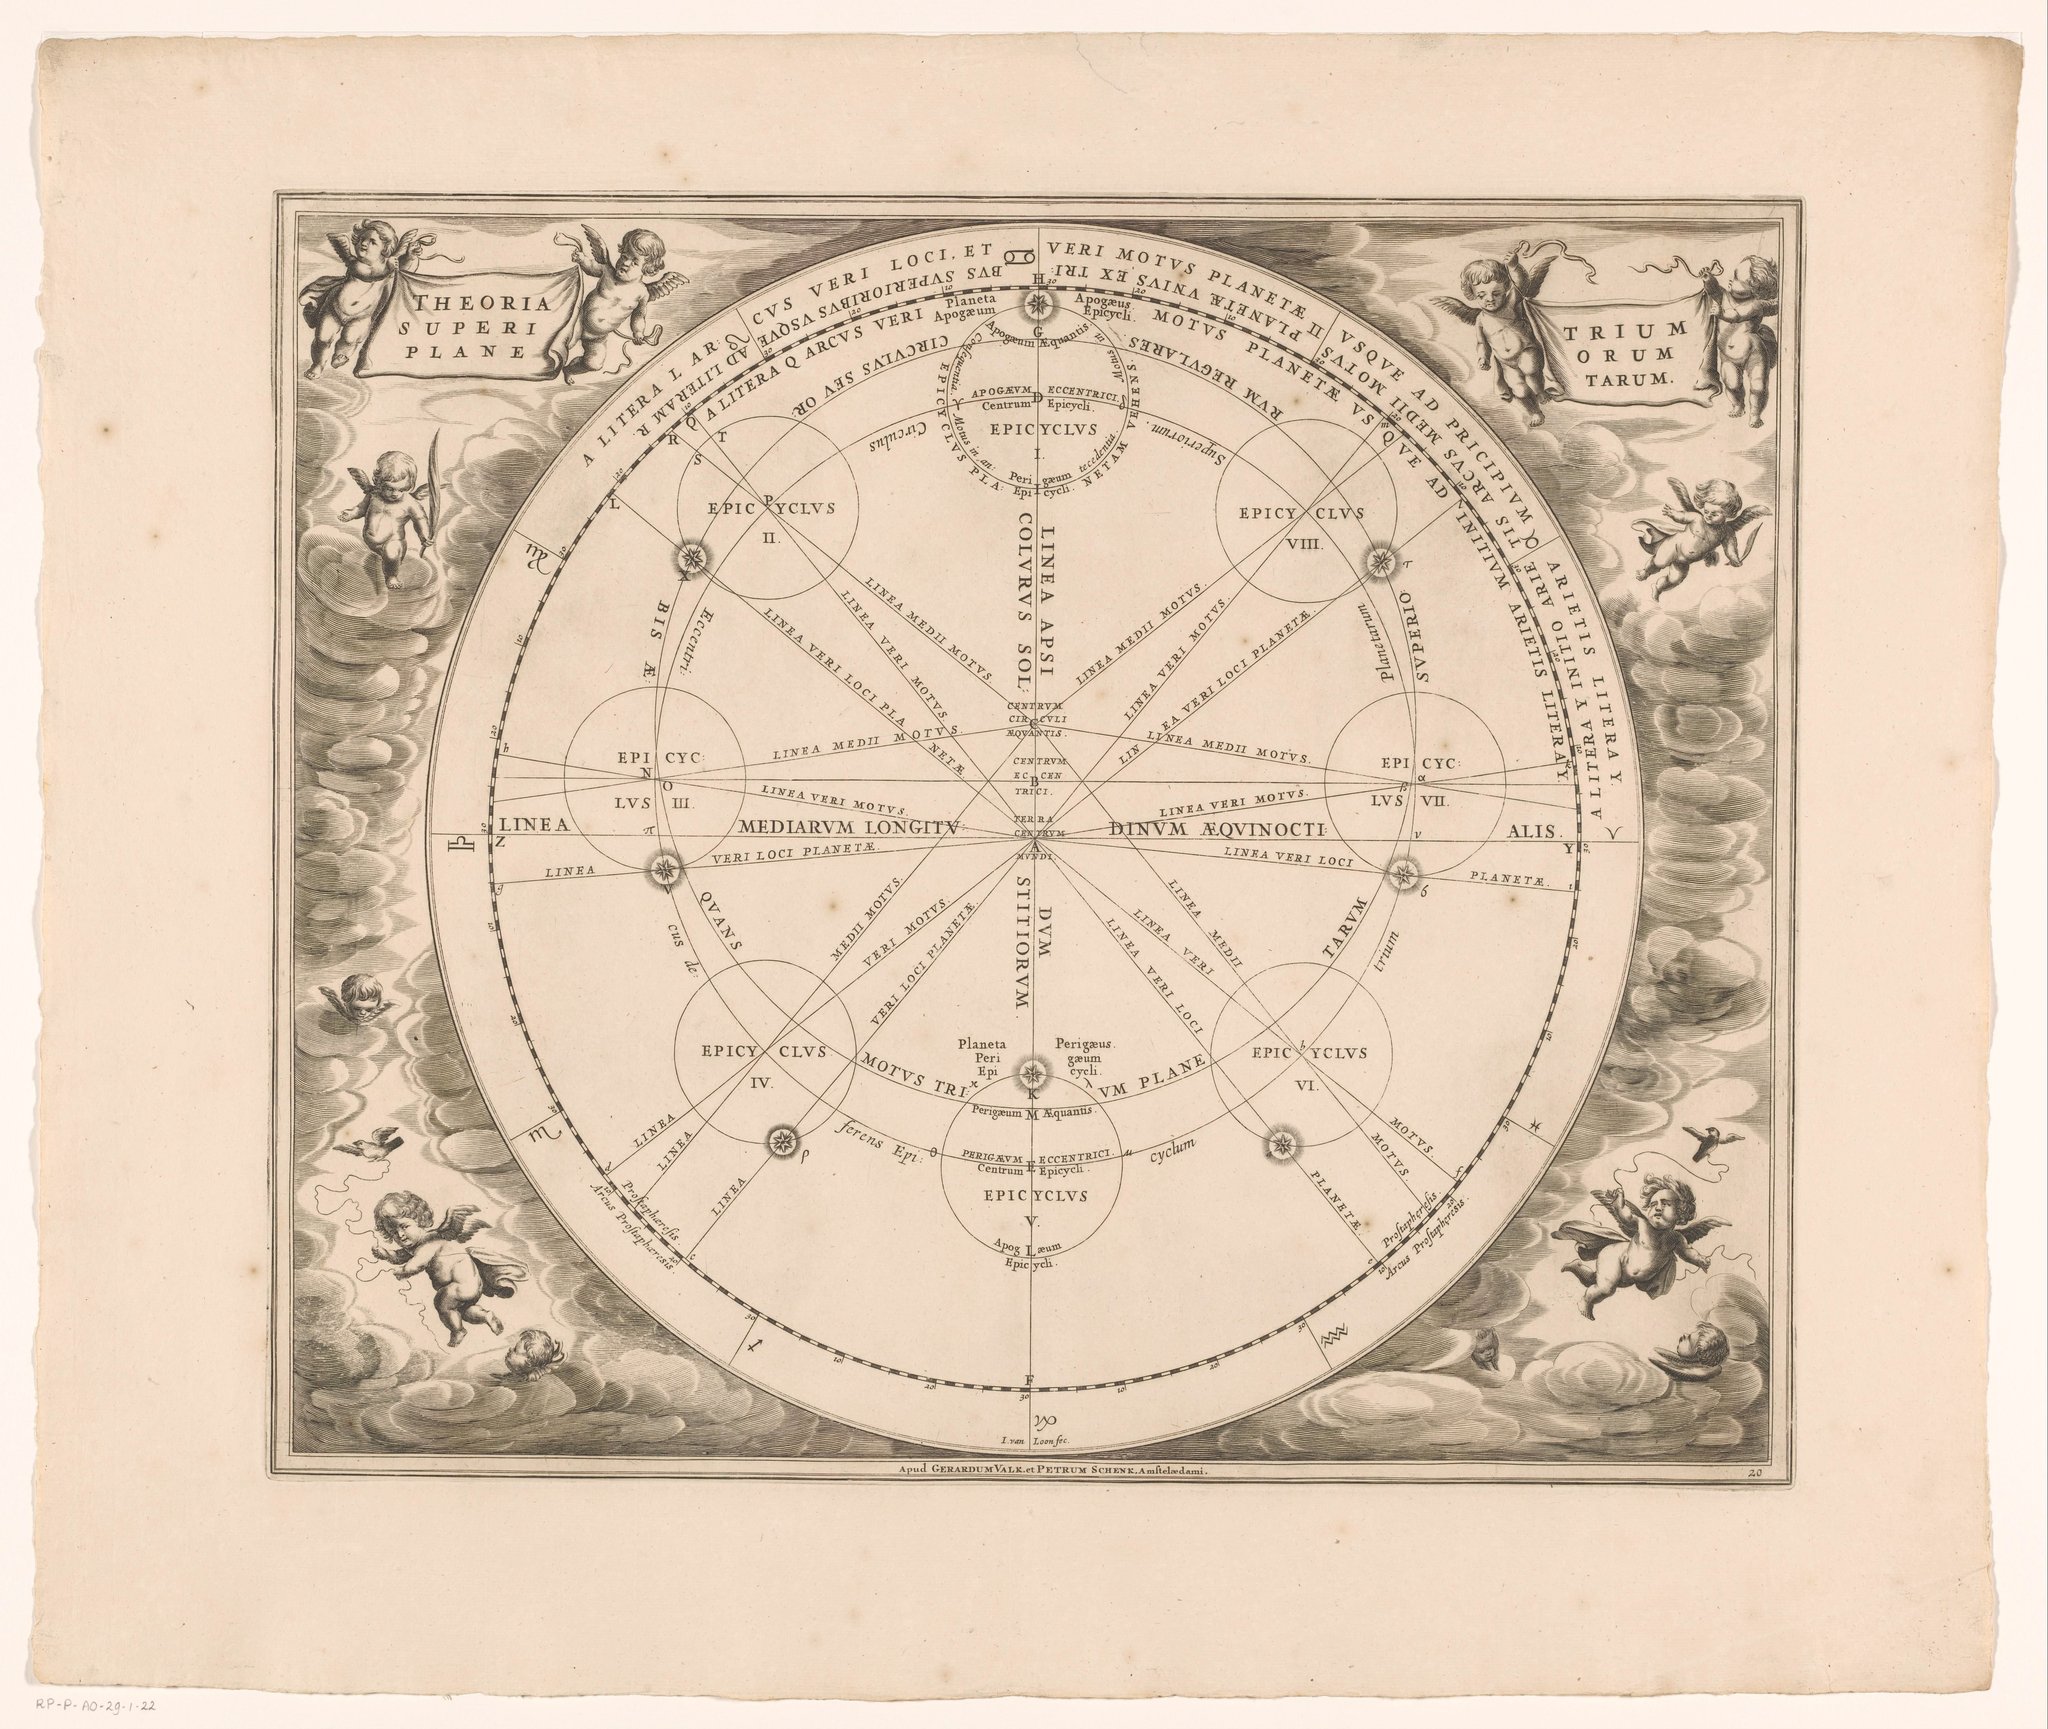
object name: map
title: Hemelkaart met een theorie over epicykels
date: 1660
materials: paper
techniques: engraving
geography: amsterdam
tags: zodiac; the twelve zodiacal signs together, star-chart, star map, planets; planetary system, solar system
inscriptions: collector's mark: Lugt 2228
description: Prent ook gebruikt in: Cellarius, Andreas. Harmonia Macrocosmica seu Atlas Universalis et Novus. Amsterdam: Pieter Schenk (I) en Gerard Valck, 1708. Zie ook: Gent, Rob van. De hemelatlas van Andreas Cellarius: het meesterwerk van een vergeten Hollandse kosmograaf. In: Caert-Thresoor, jaargang 19, nr. 1, 2000.